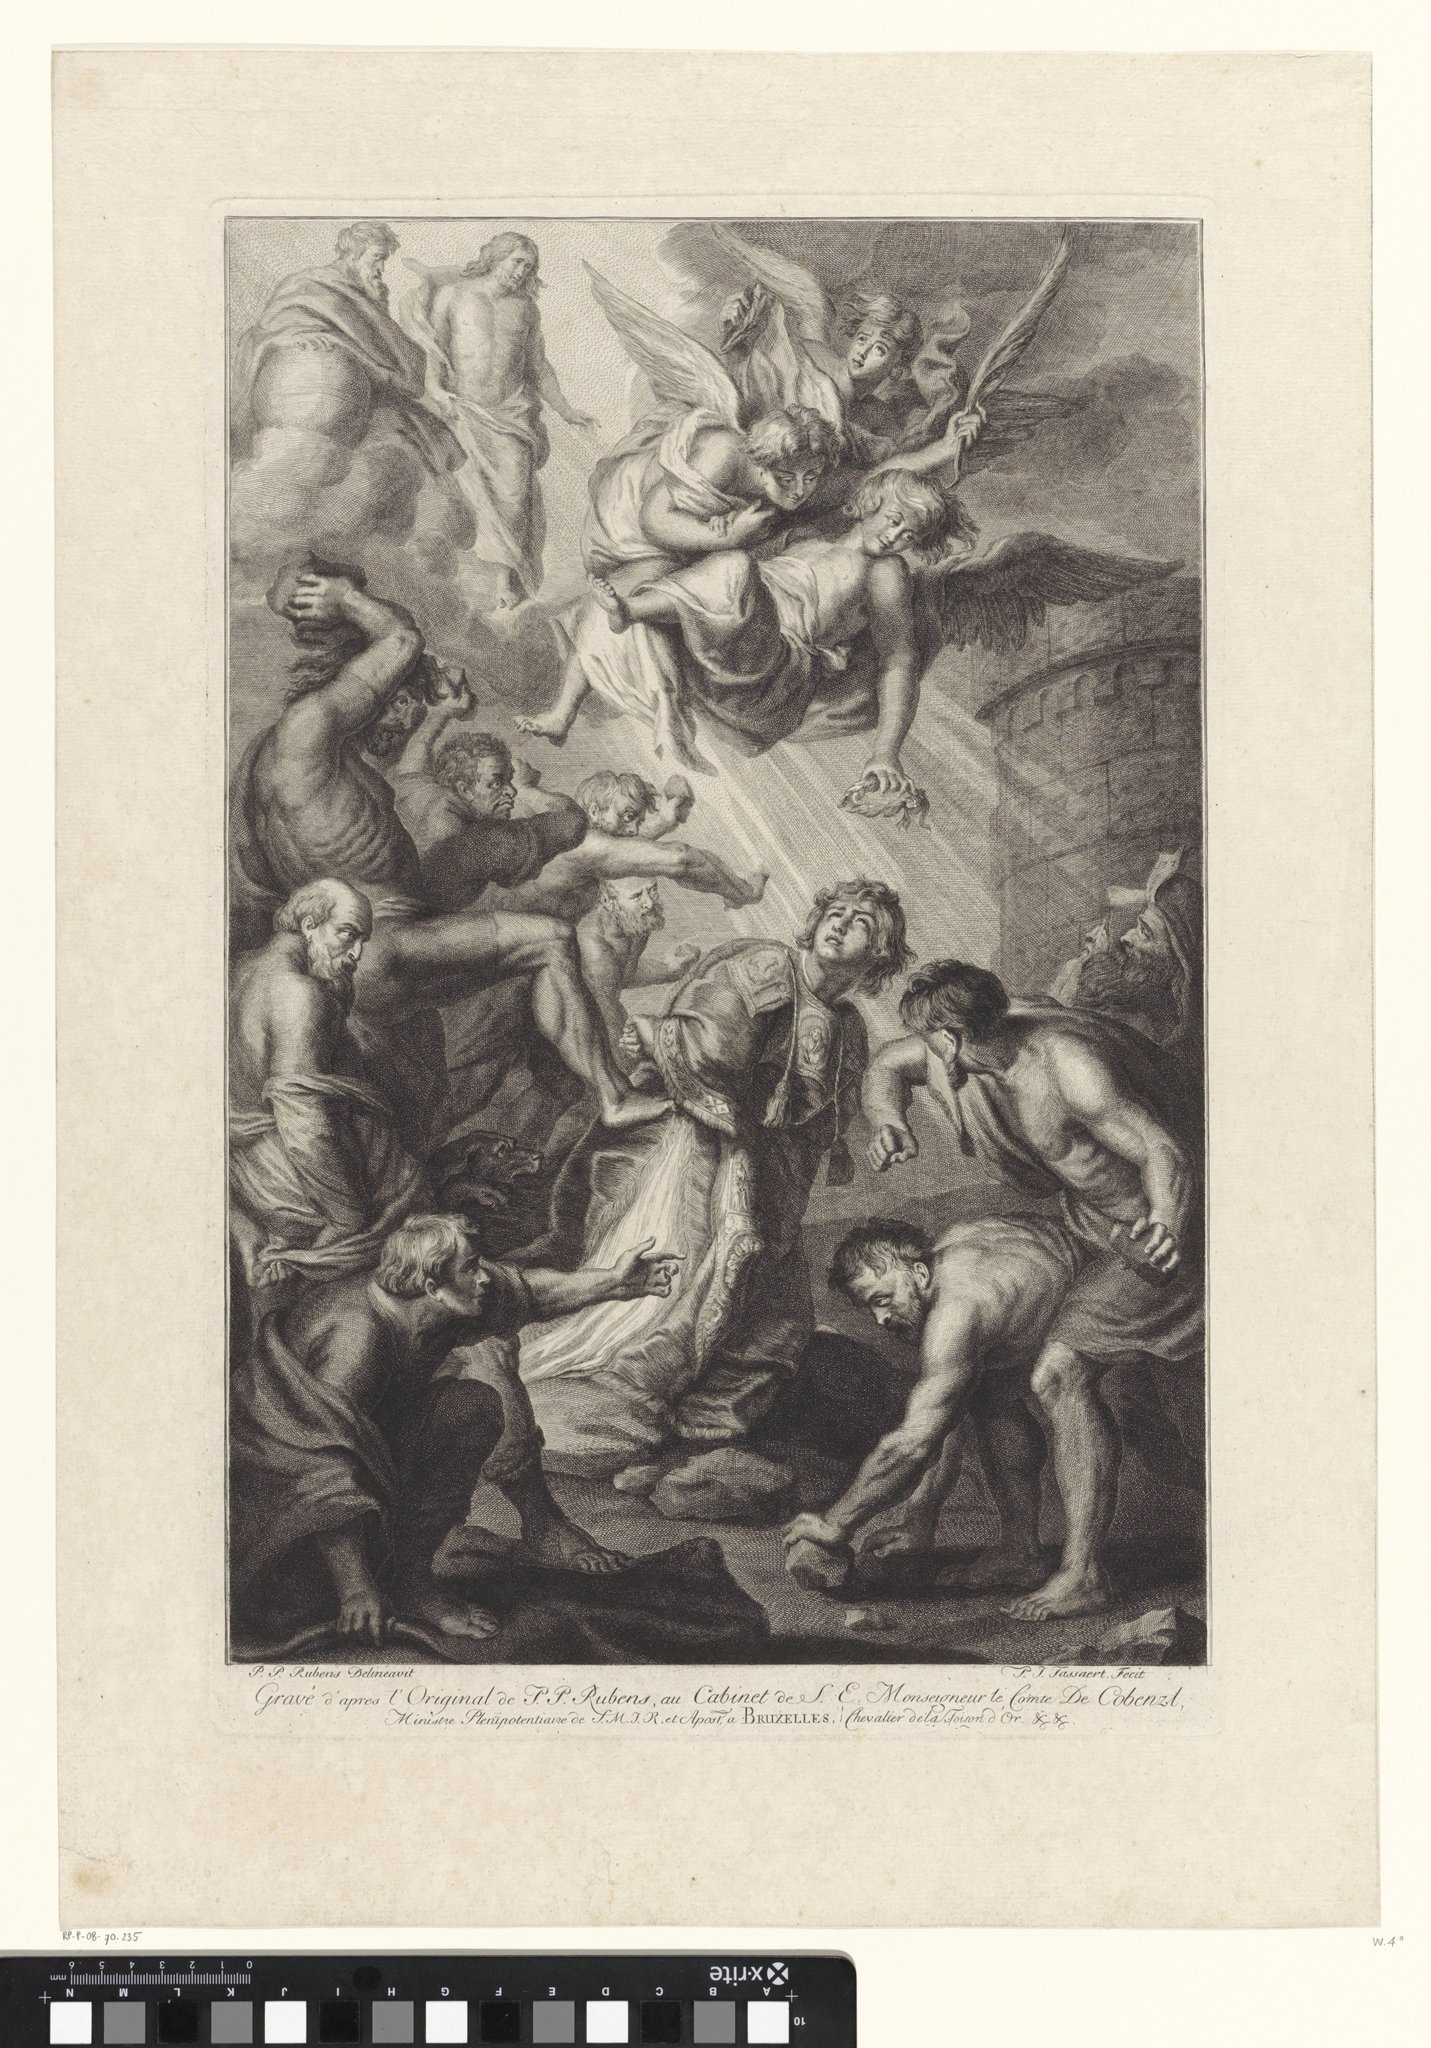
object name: print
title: Martelaarschap van H. Stefanus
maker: philippe joseph tassaert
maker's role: print maker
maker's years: 1732-1803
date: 1742-1803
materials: paper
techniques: engraving, etching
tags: martyrdom and death of stephen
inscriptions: collector's mark: Lugt 240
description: De steniging van de heilige Stefanus. In de hemel God de Vader en Christus en een drietal engelen met een lauwerkrans en palmtak.